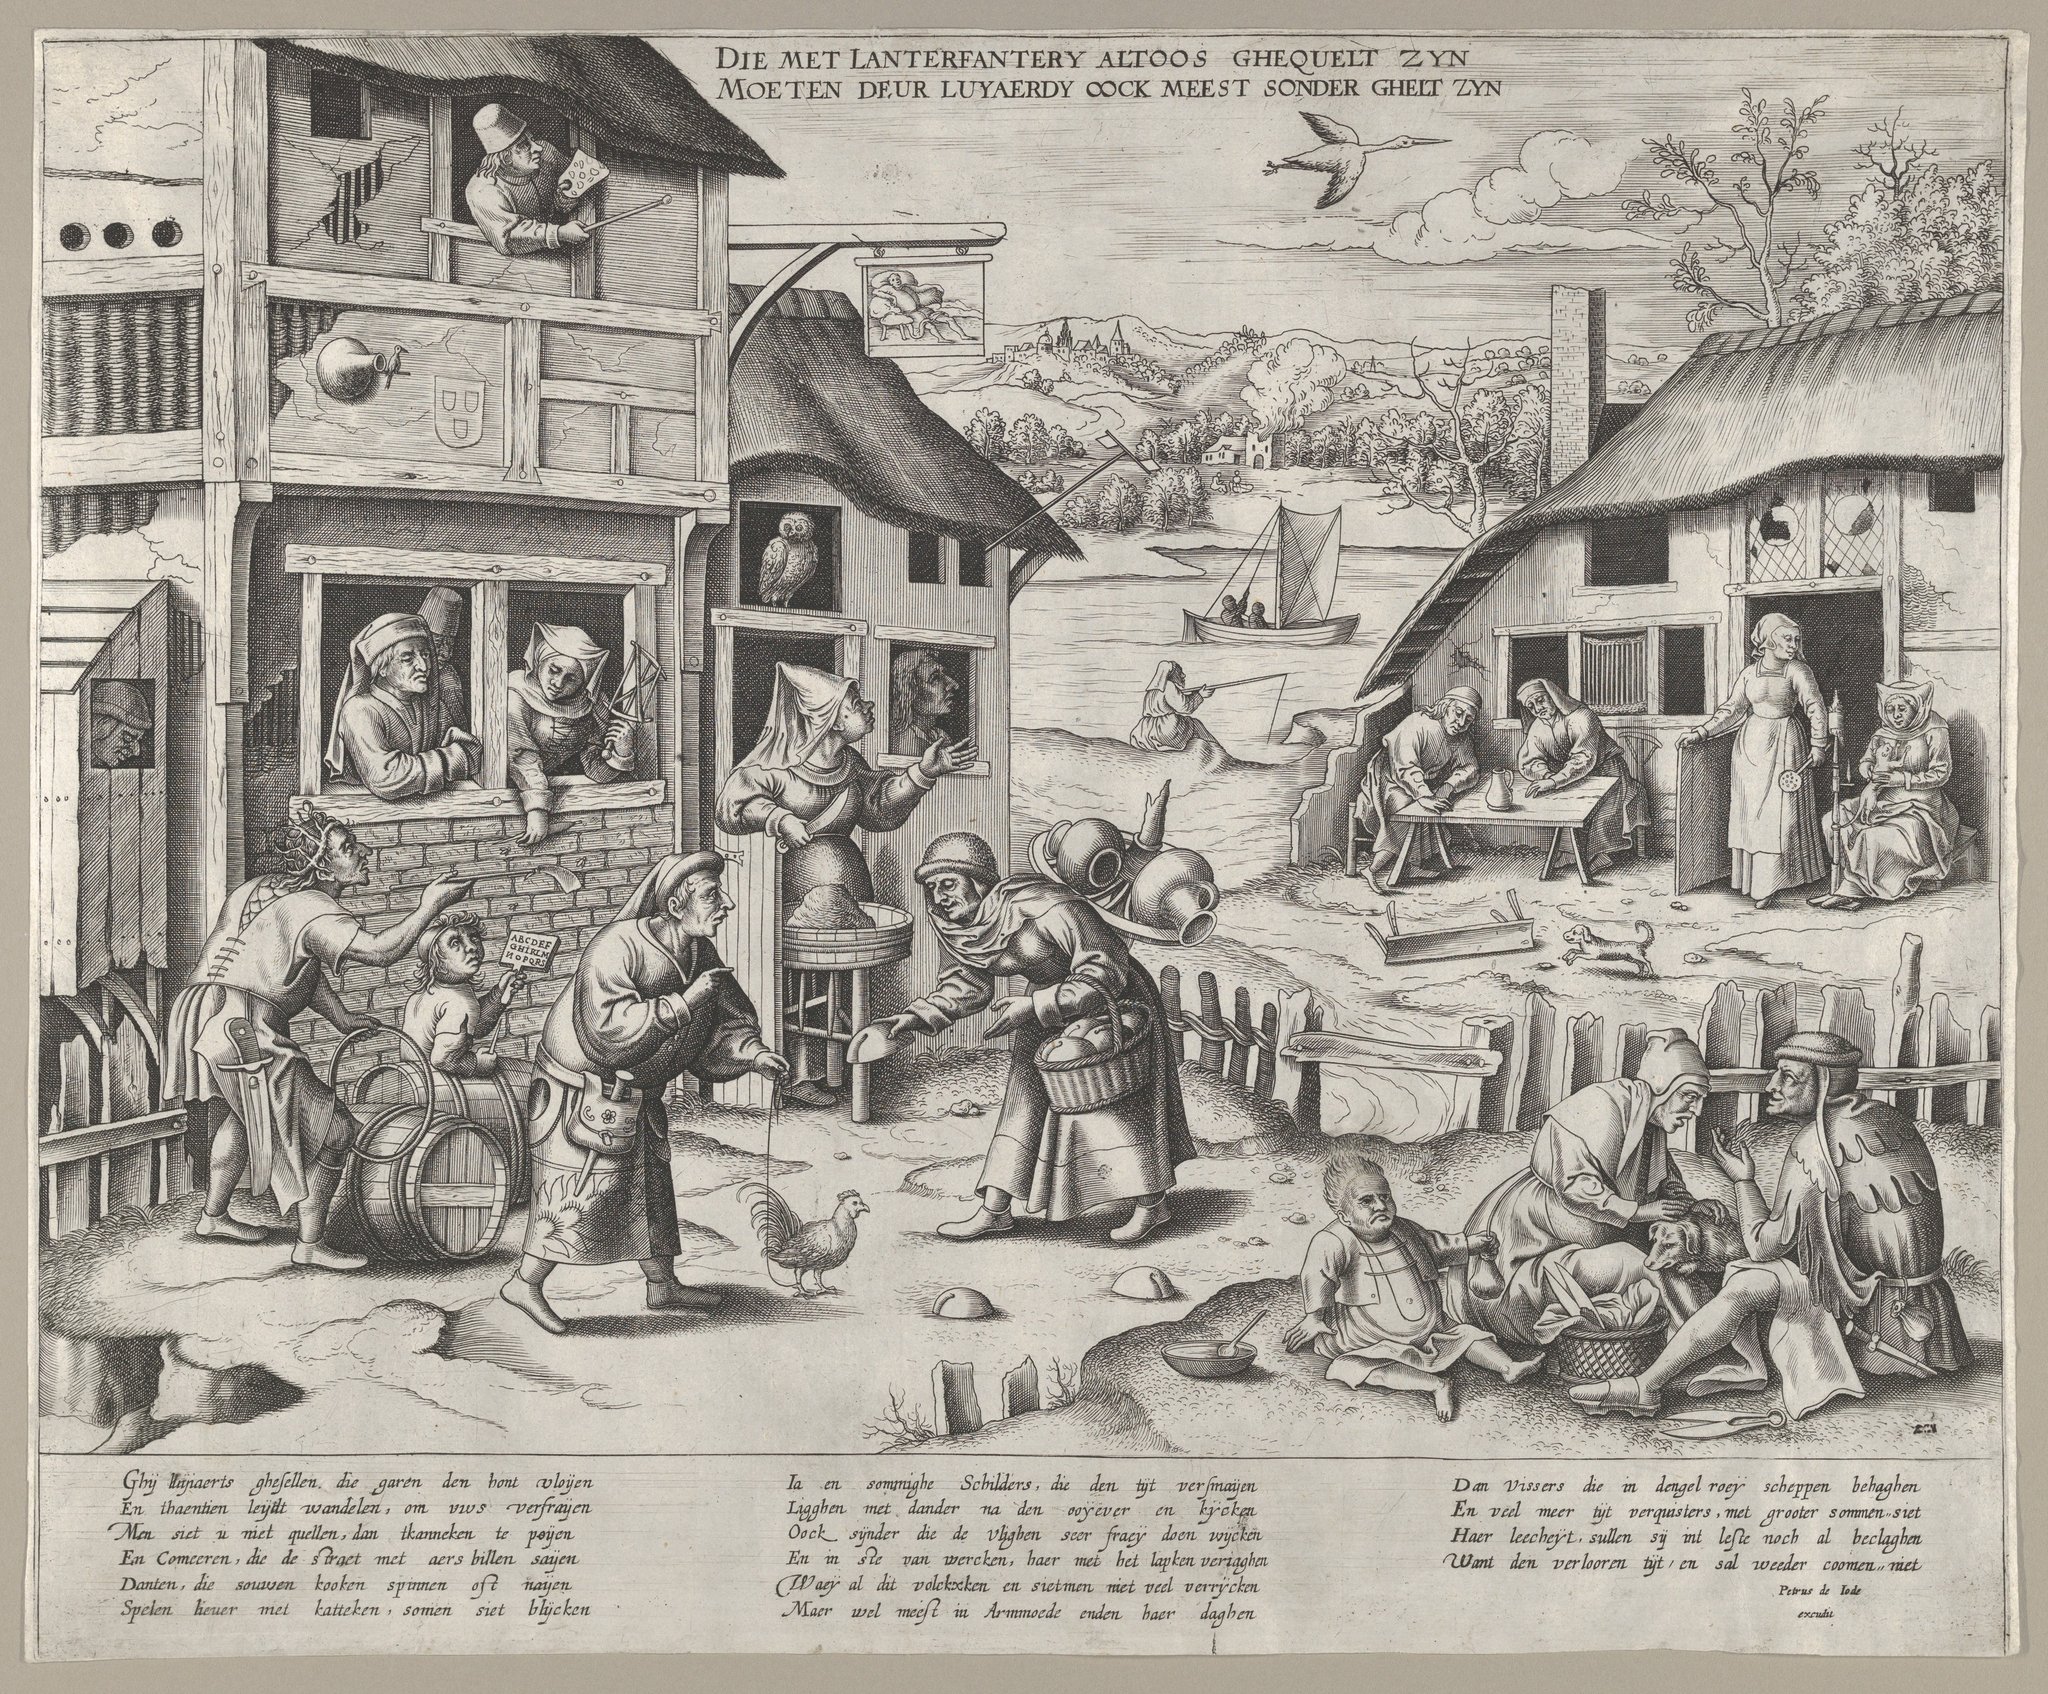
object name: print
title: A Flemish Village with Ten Proverbs on Laziness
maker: frans huys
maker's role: artist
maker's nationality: netherlandish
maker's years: 1522-1562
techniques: engraving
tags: human figures,birds,houses,villages,working